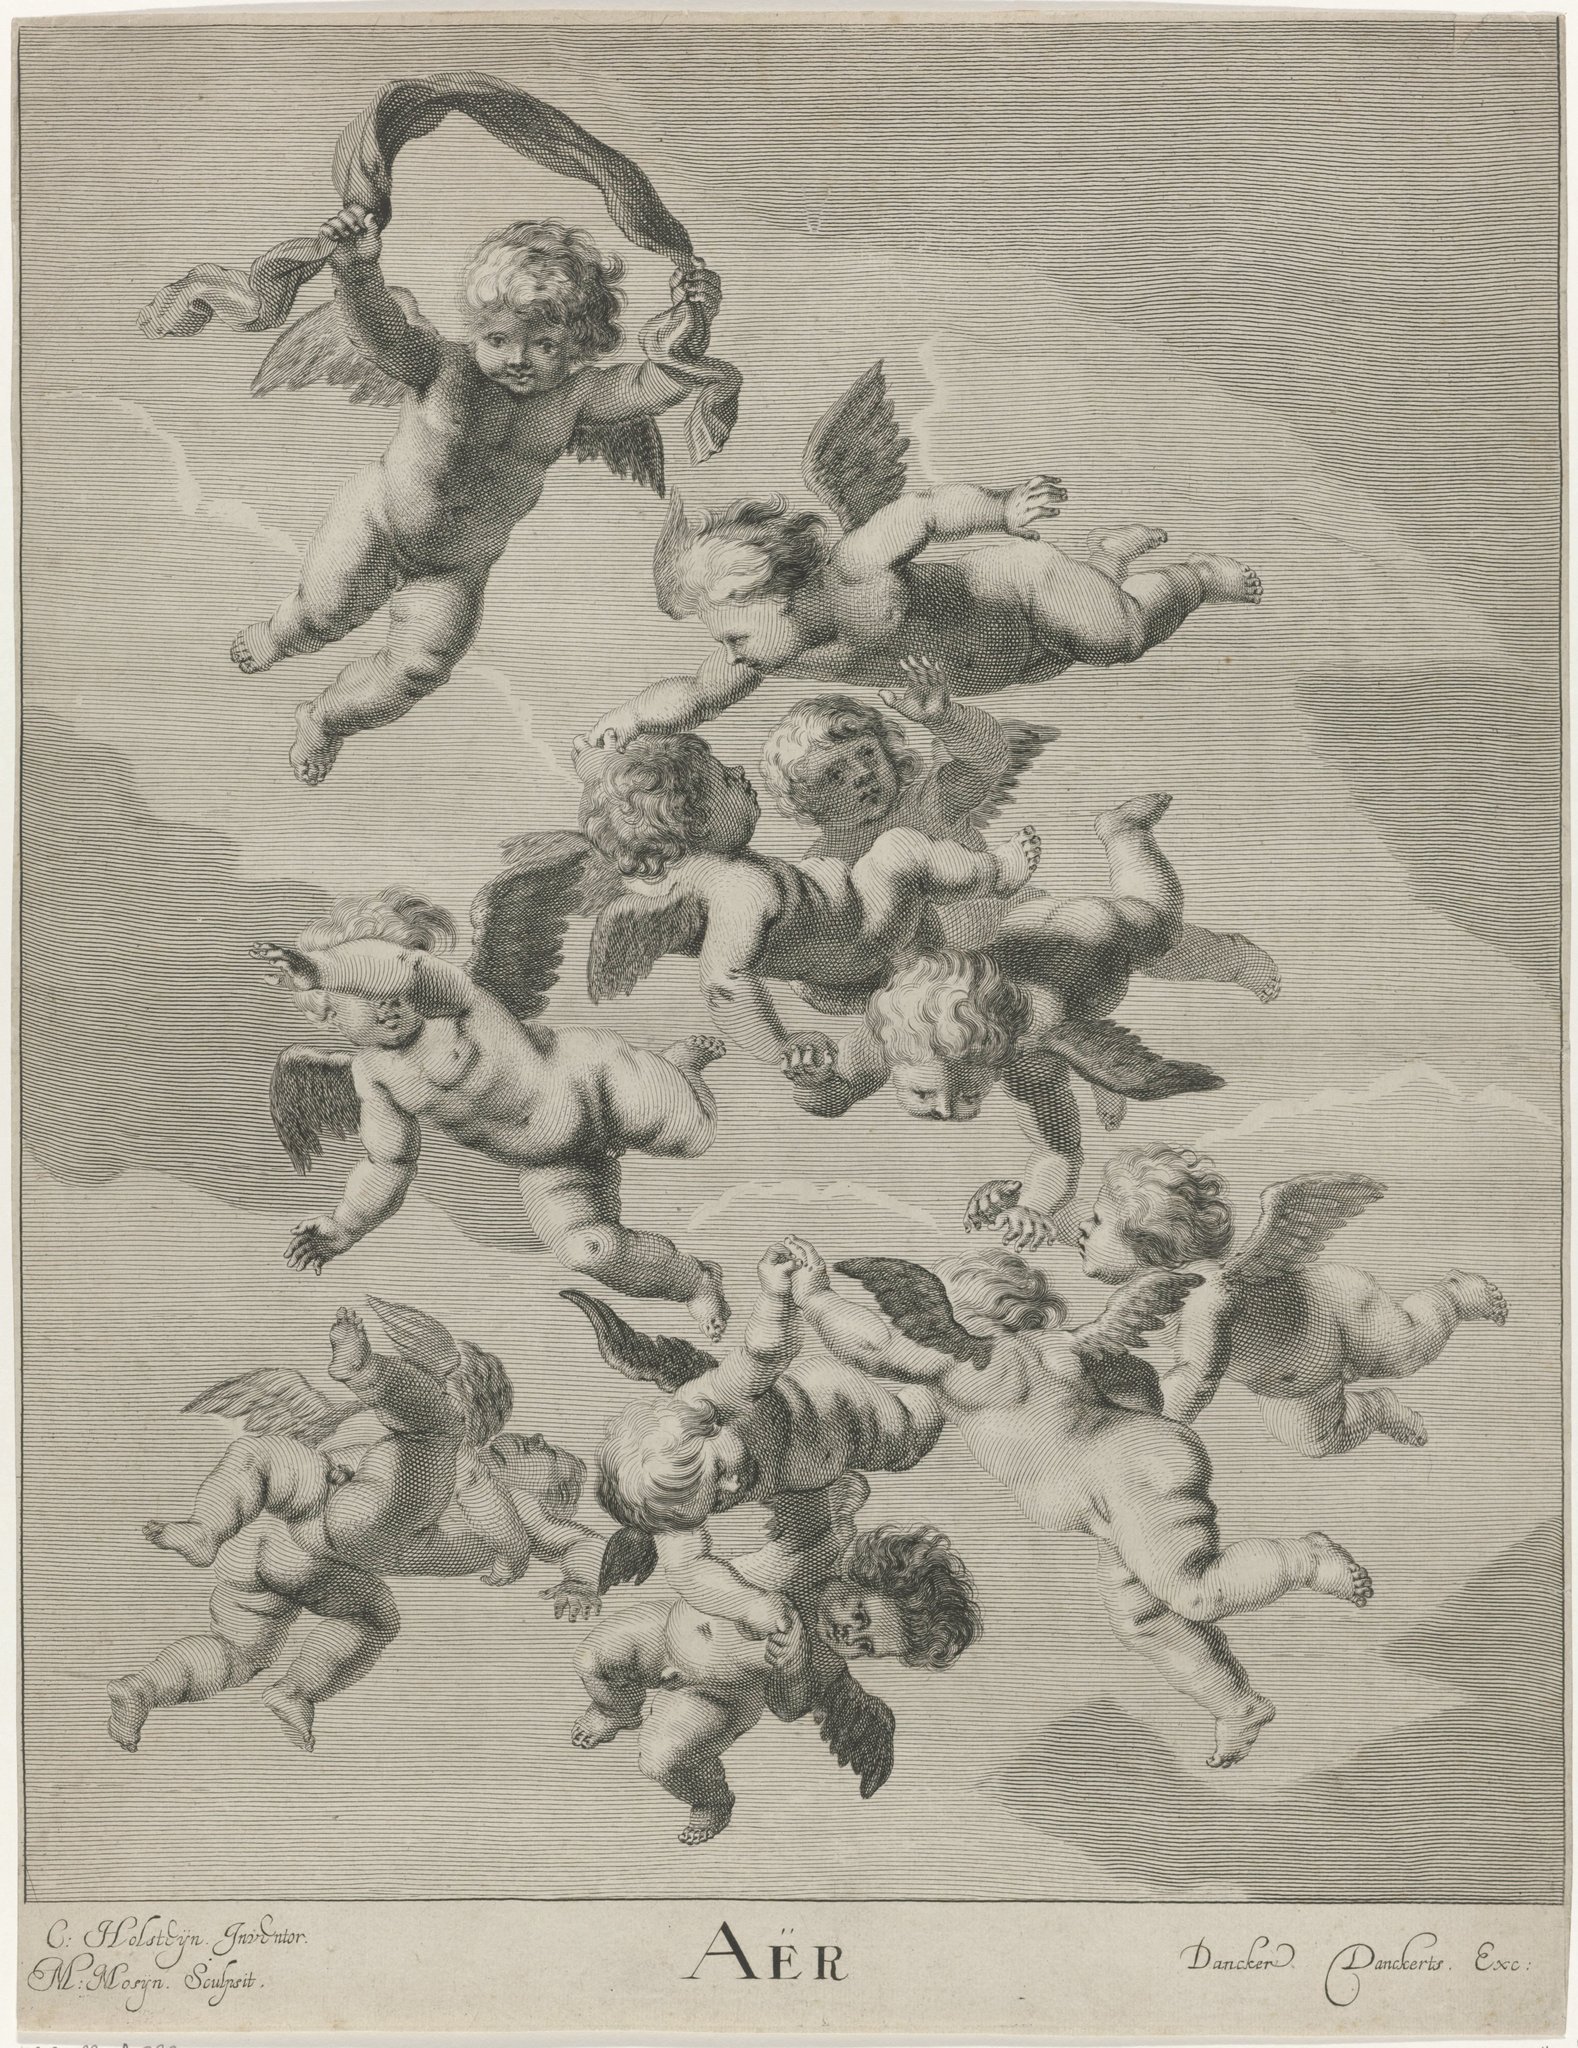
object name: print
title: Aër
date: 1640-1655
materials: paper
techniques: engraving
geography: amsterdam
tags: air (one of the four elements), cupids: 'amores', 'amoretti', 'putti'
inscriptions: collector's mark: Lugt 2228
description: Vliegende putti in de lucht. Prent uit een serie van de vier elementen.